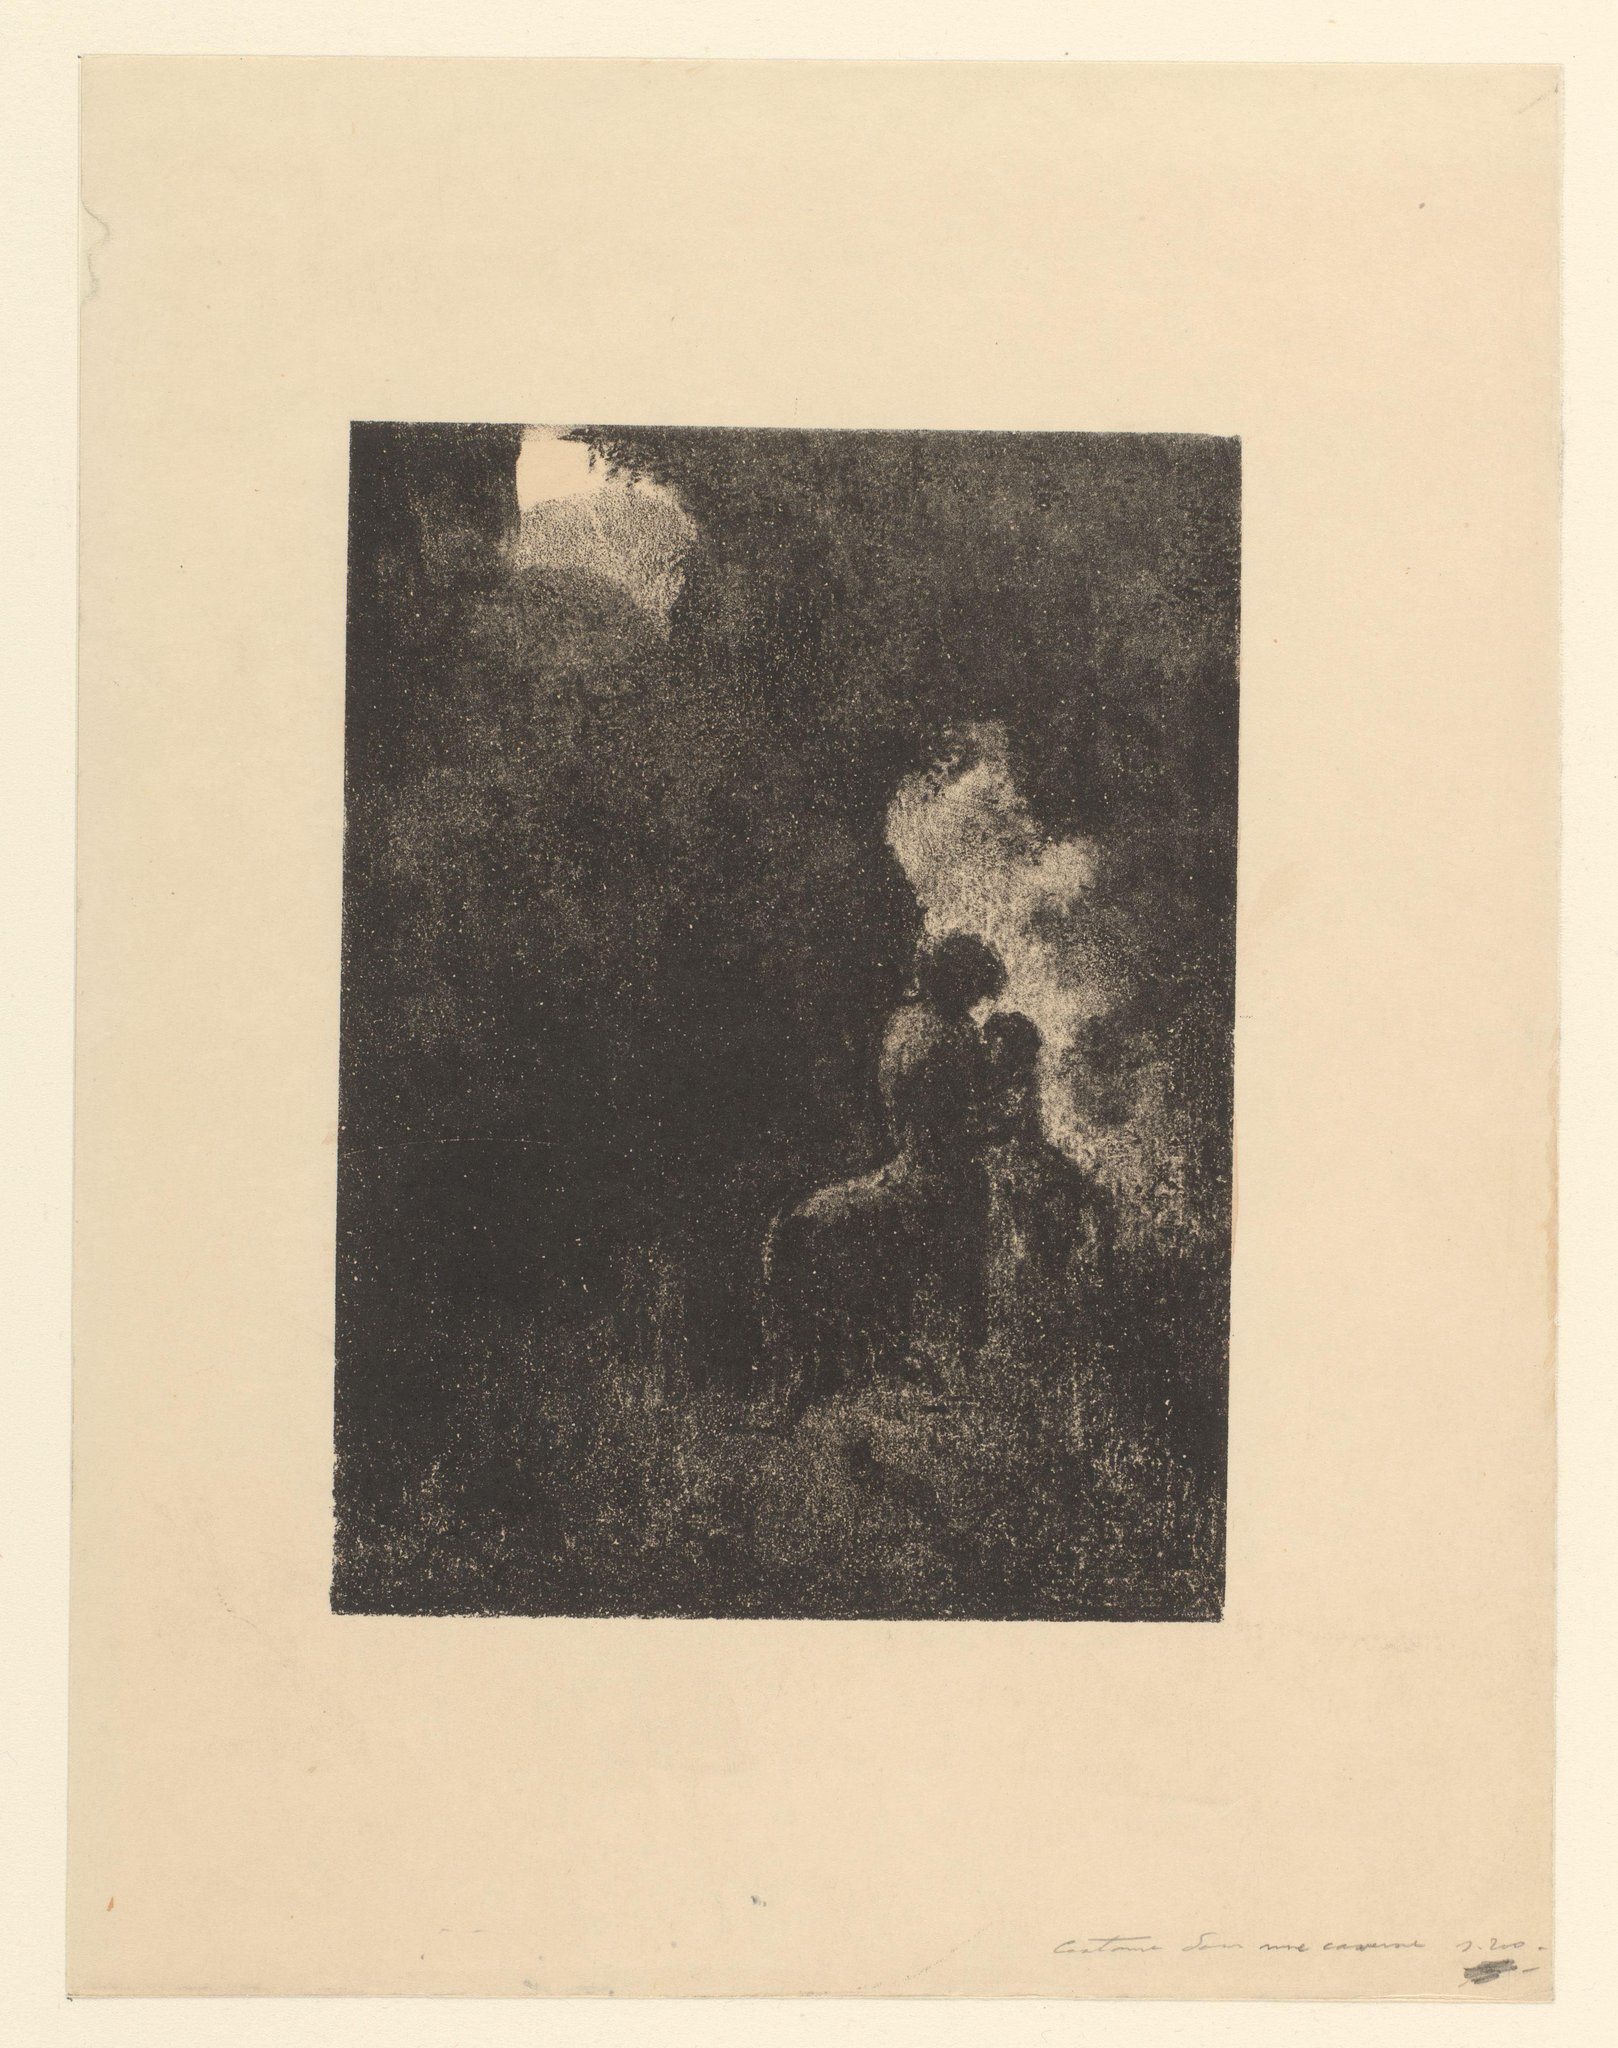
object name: print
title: Centauren in een grot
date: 1920-1935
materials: paper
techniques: lithograph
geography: paris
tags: centaurs, cave, grotto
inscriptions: collector's mark: Lugt 2228, inscription: ‘Centaure dans une caverne [...] 200.’, collector's mark: Lugt 2760